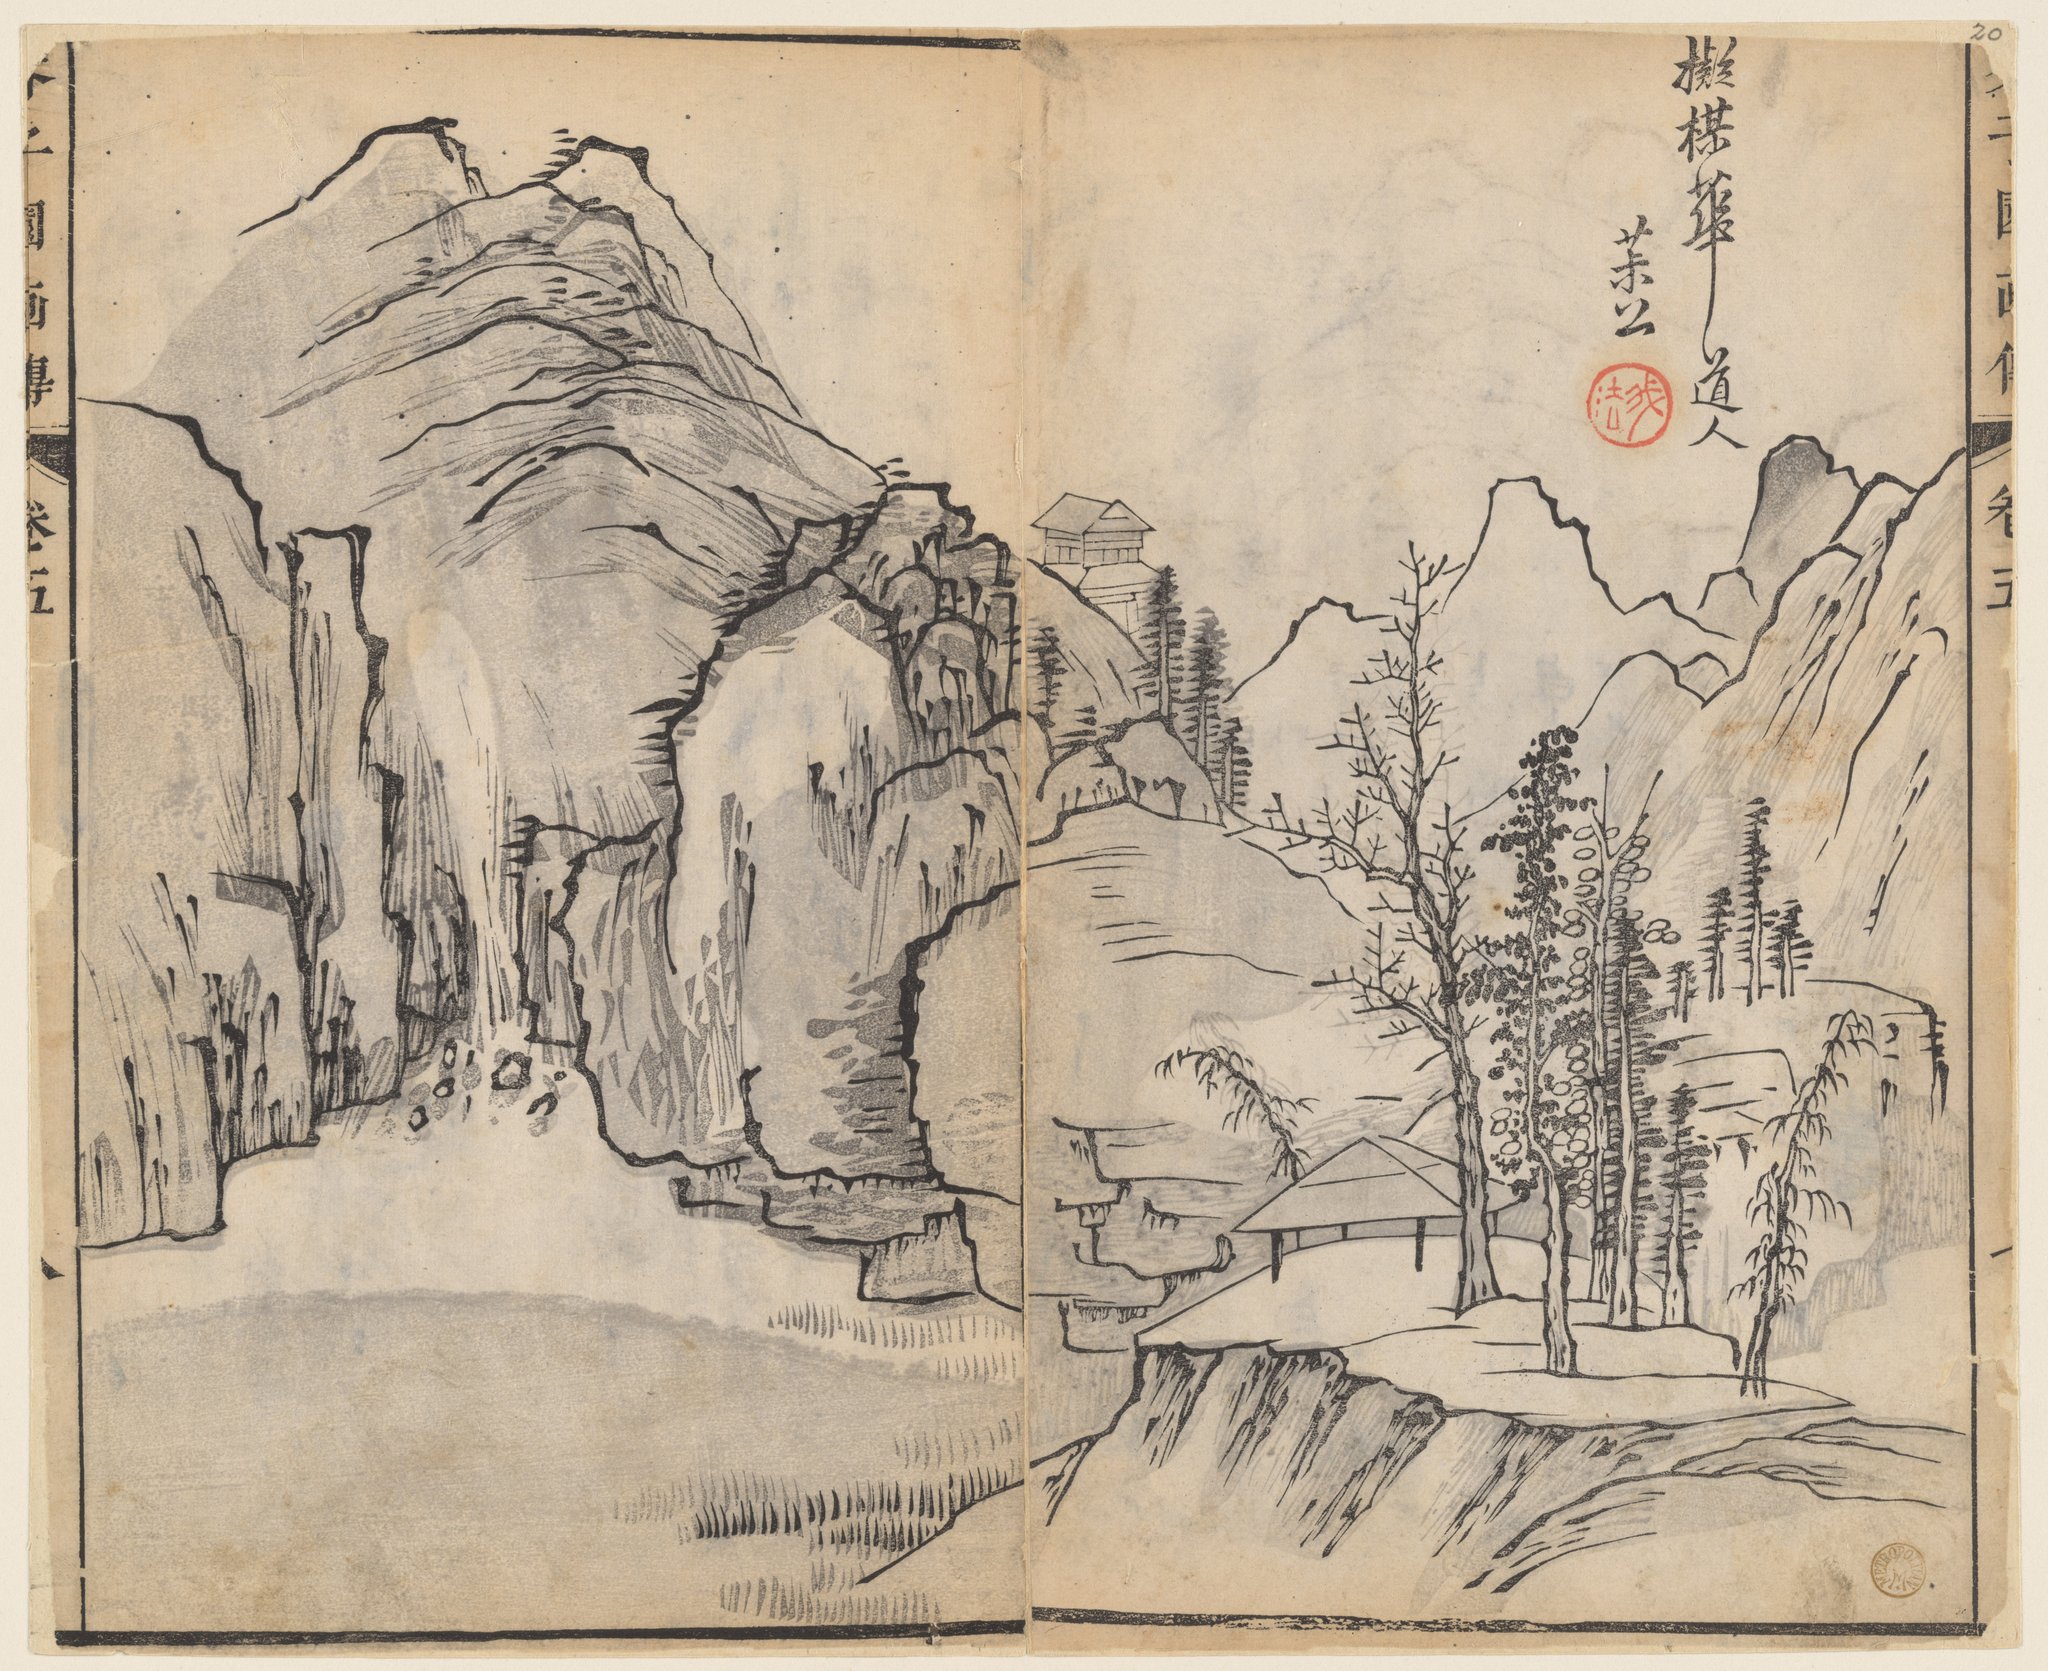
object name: print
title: Page from the Mustard Seed Garden Manual of Painting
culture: chinese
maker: wang gai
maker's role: artist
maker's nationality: chinese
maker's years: 1645-1710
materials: ink, paper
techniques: woodblock print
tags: landscapes